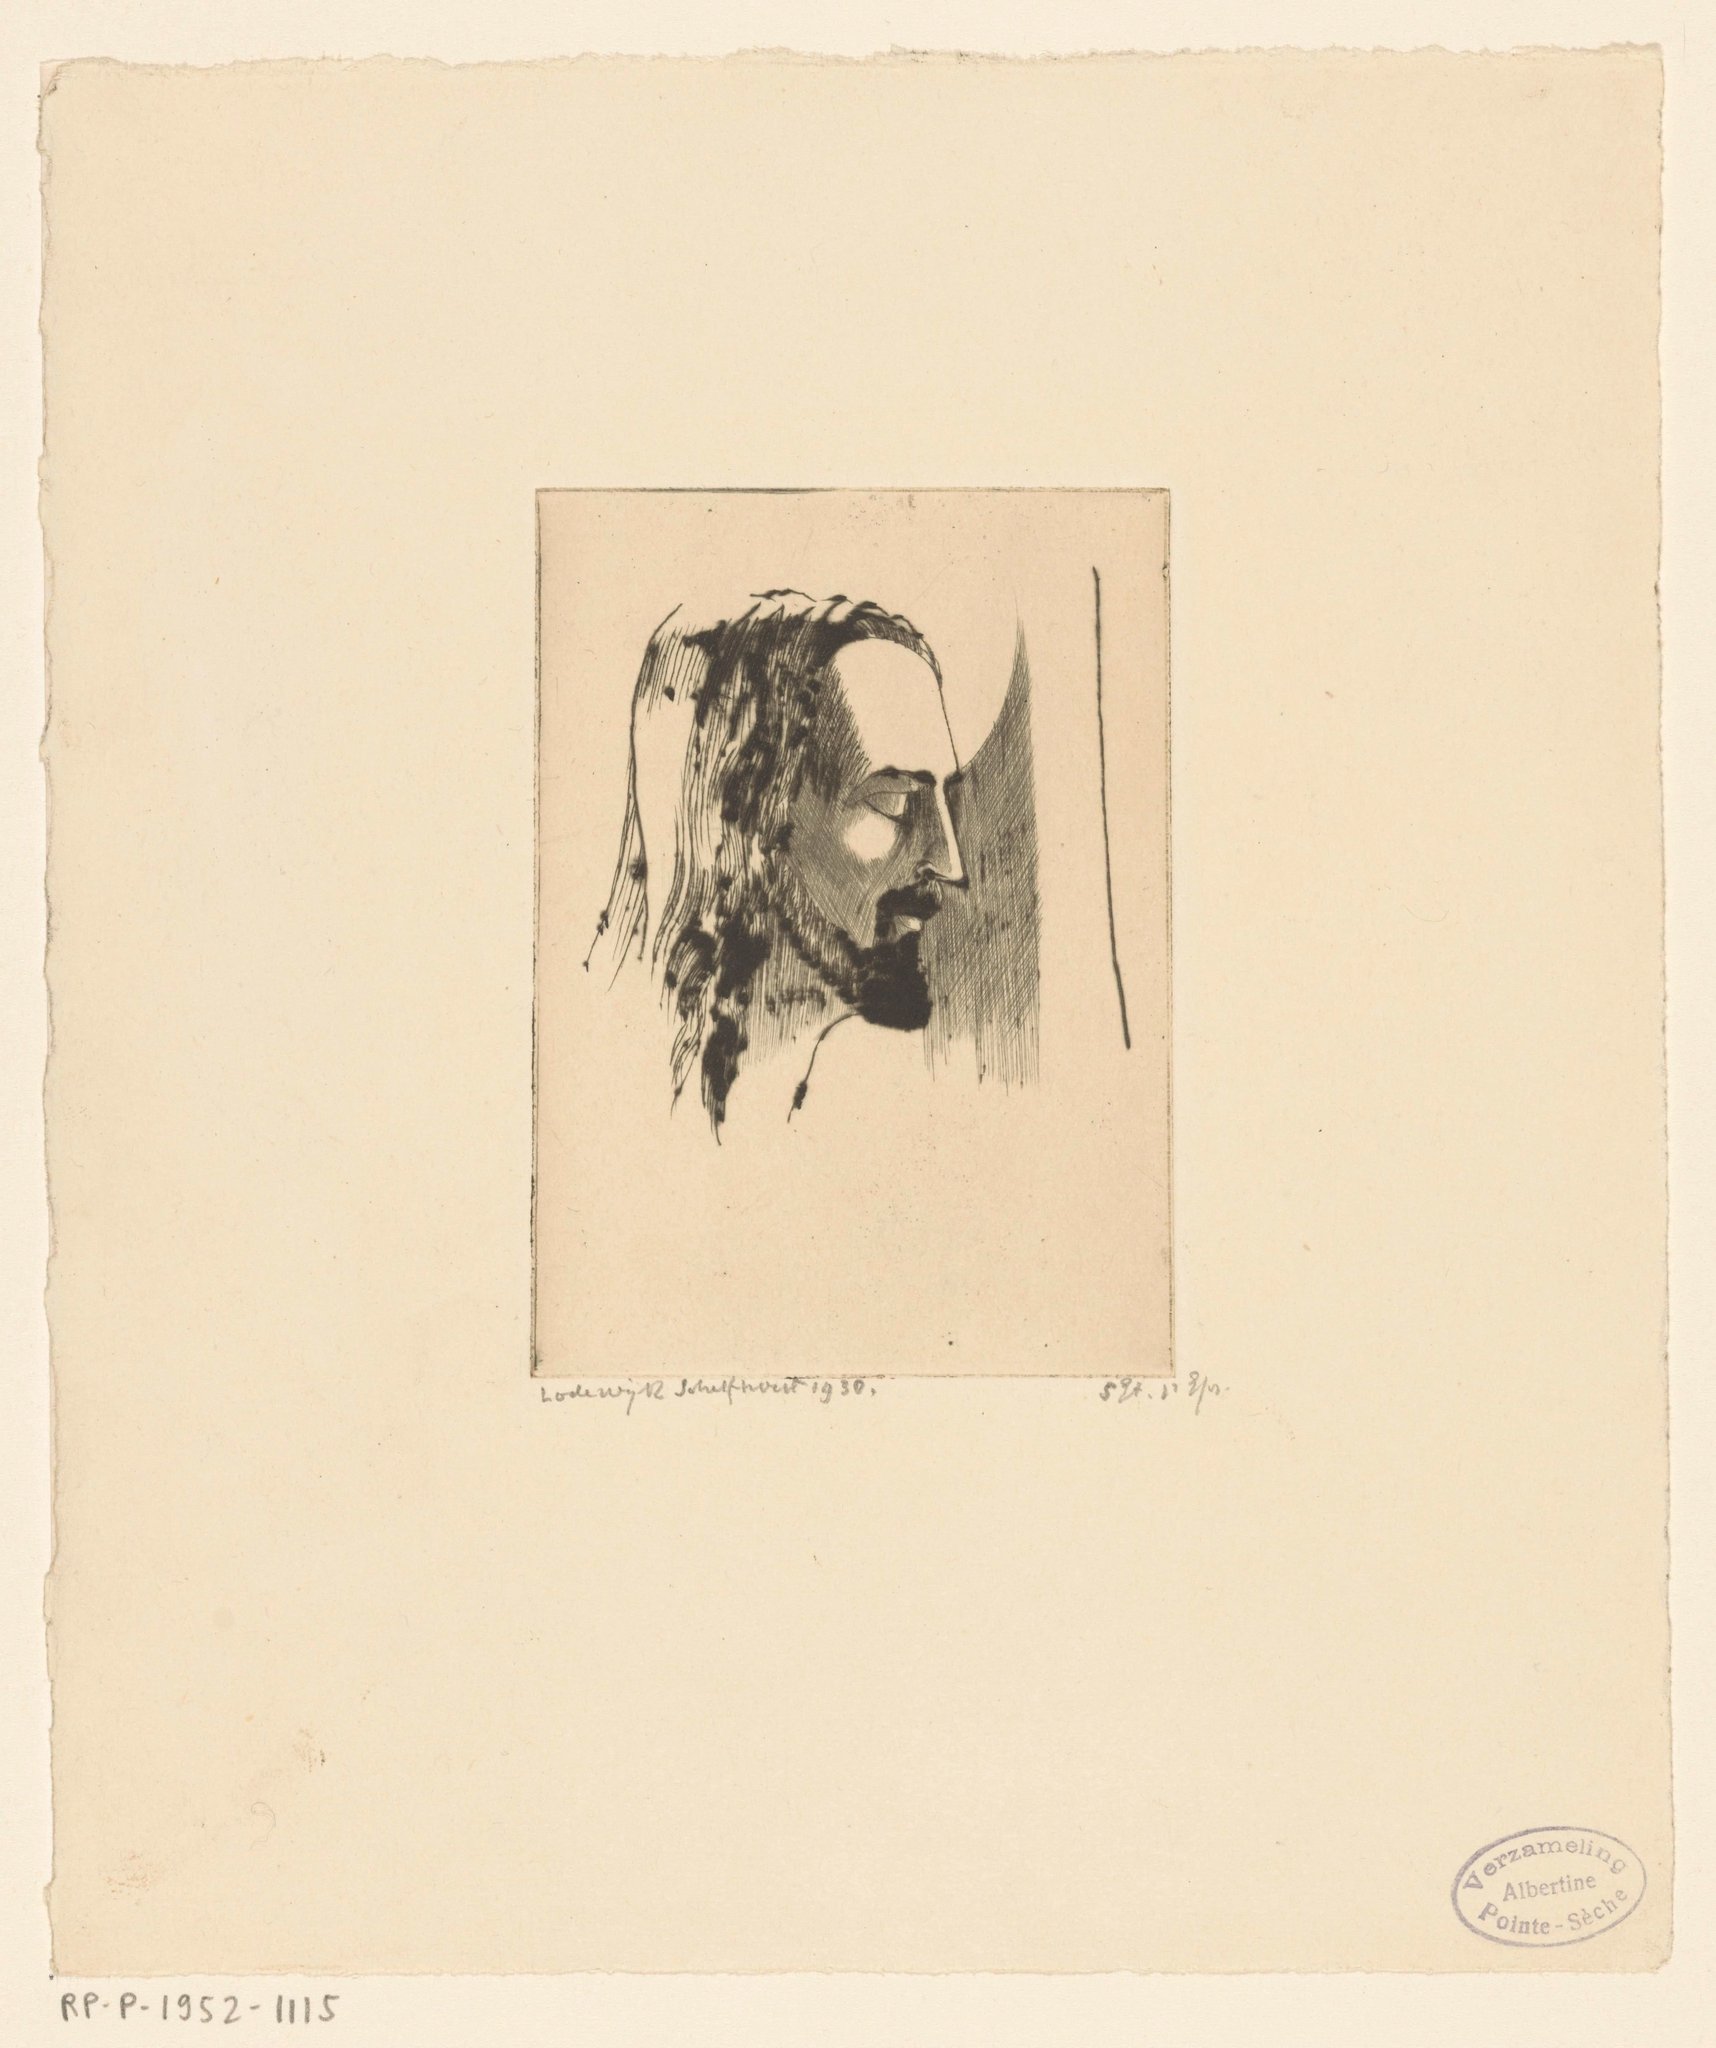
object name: print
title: Christus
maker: lodewijk schelfhout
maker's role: draughtsman, print maker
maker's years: 1881-1943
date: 1930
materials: paper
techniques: drypoint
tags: eyes closed, 'portraits' of christ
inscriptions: collector's mark: Lugt 5i, collector's mark: Lugt 2228